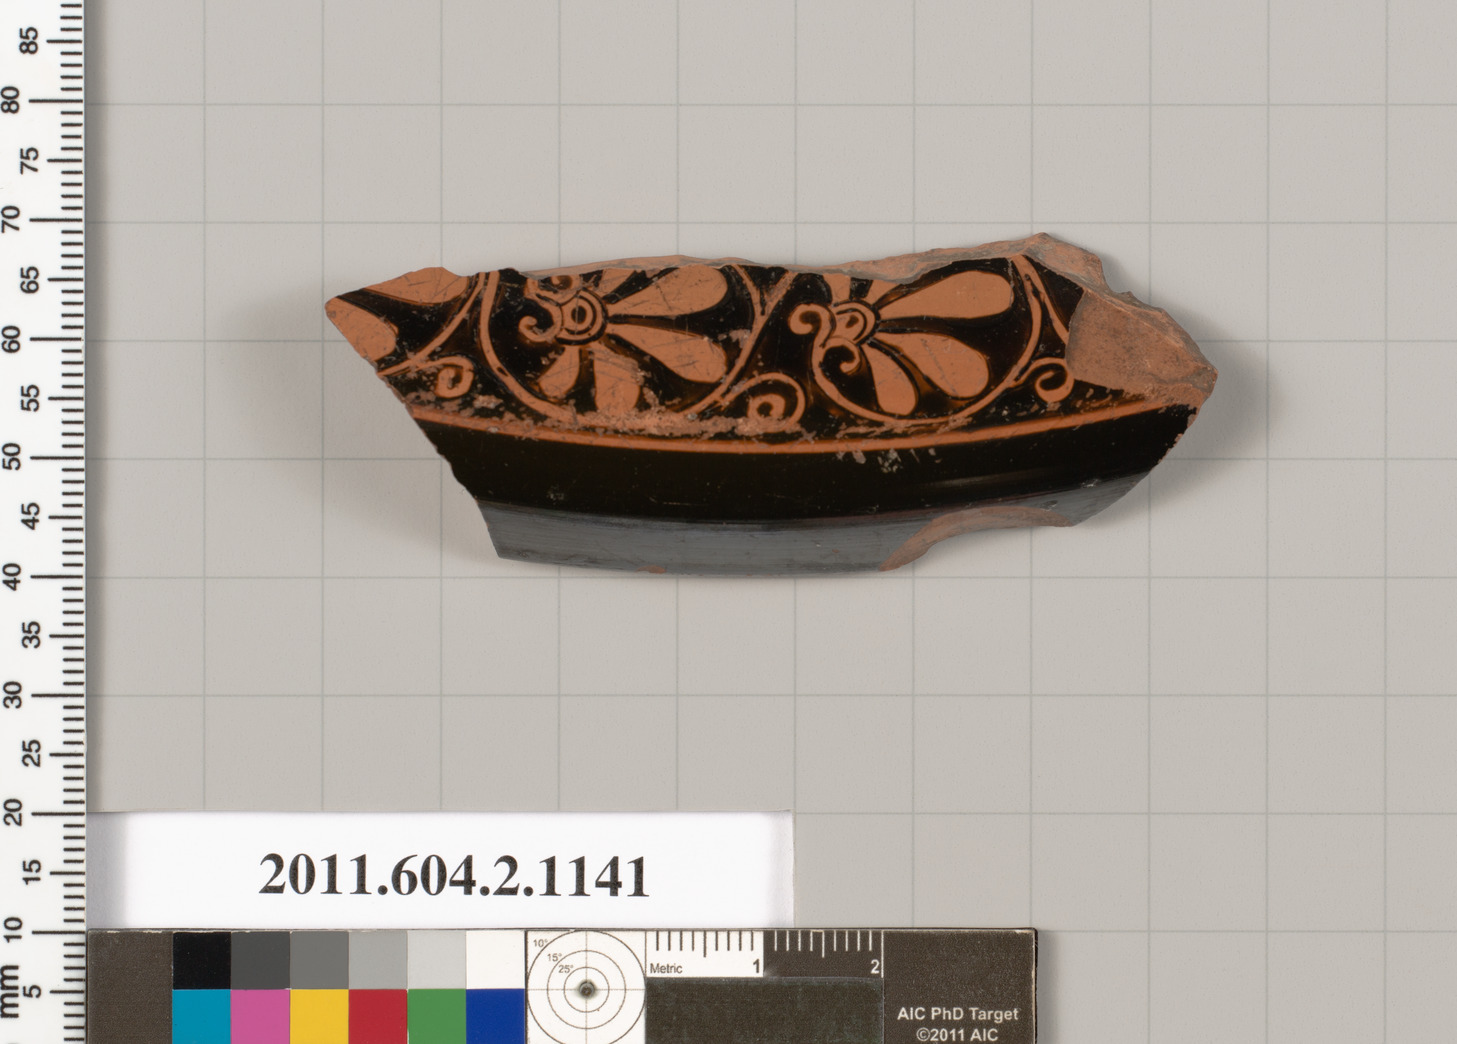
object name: pyxis fragment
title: Terracotta fragment from a pyxis lid (box)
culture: greek, attic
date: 534-501 BCE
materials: terracotta